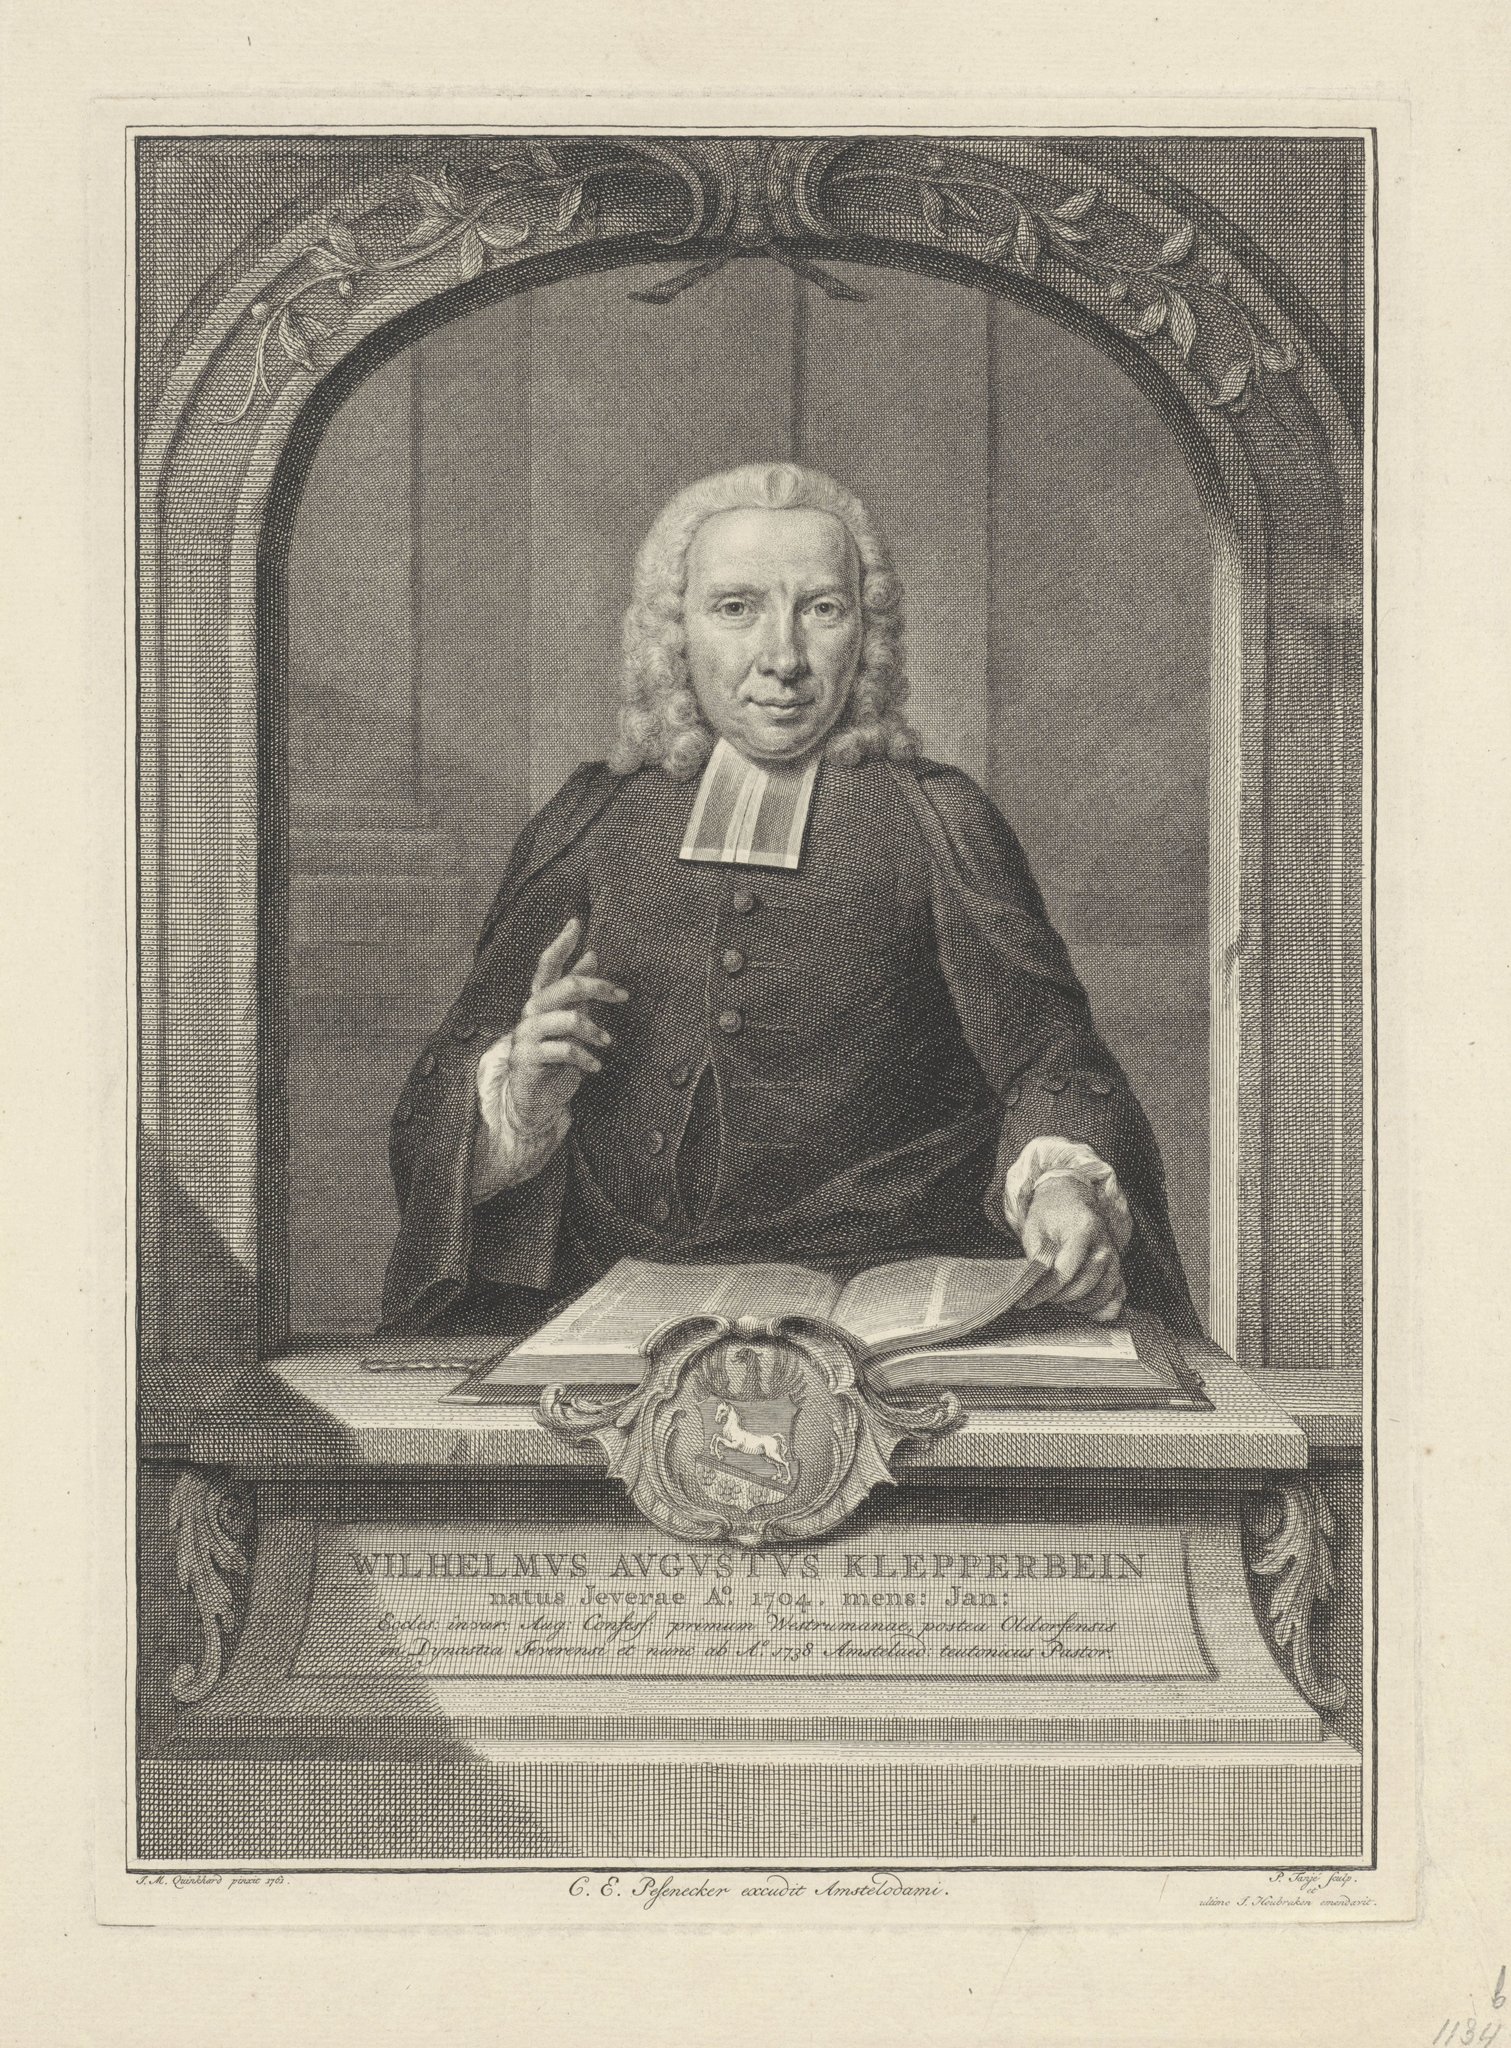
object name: print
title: Portret van Wilhelm August Klepperbein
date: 1761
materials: paper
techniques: engraving, etching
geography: amsterdam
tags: the bible as a book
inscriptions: collector's mark: Lugt 2228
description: Portret van Wilhelm August Klepperbein, luthers predikant te Amsterdam, bij een opengeslagen bijbel. Midden onder zijn wapenschild.